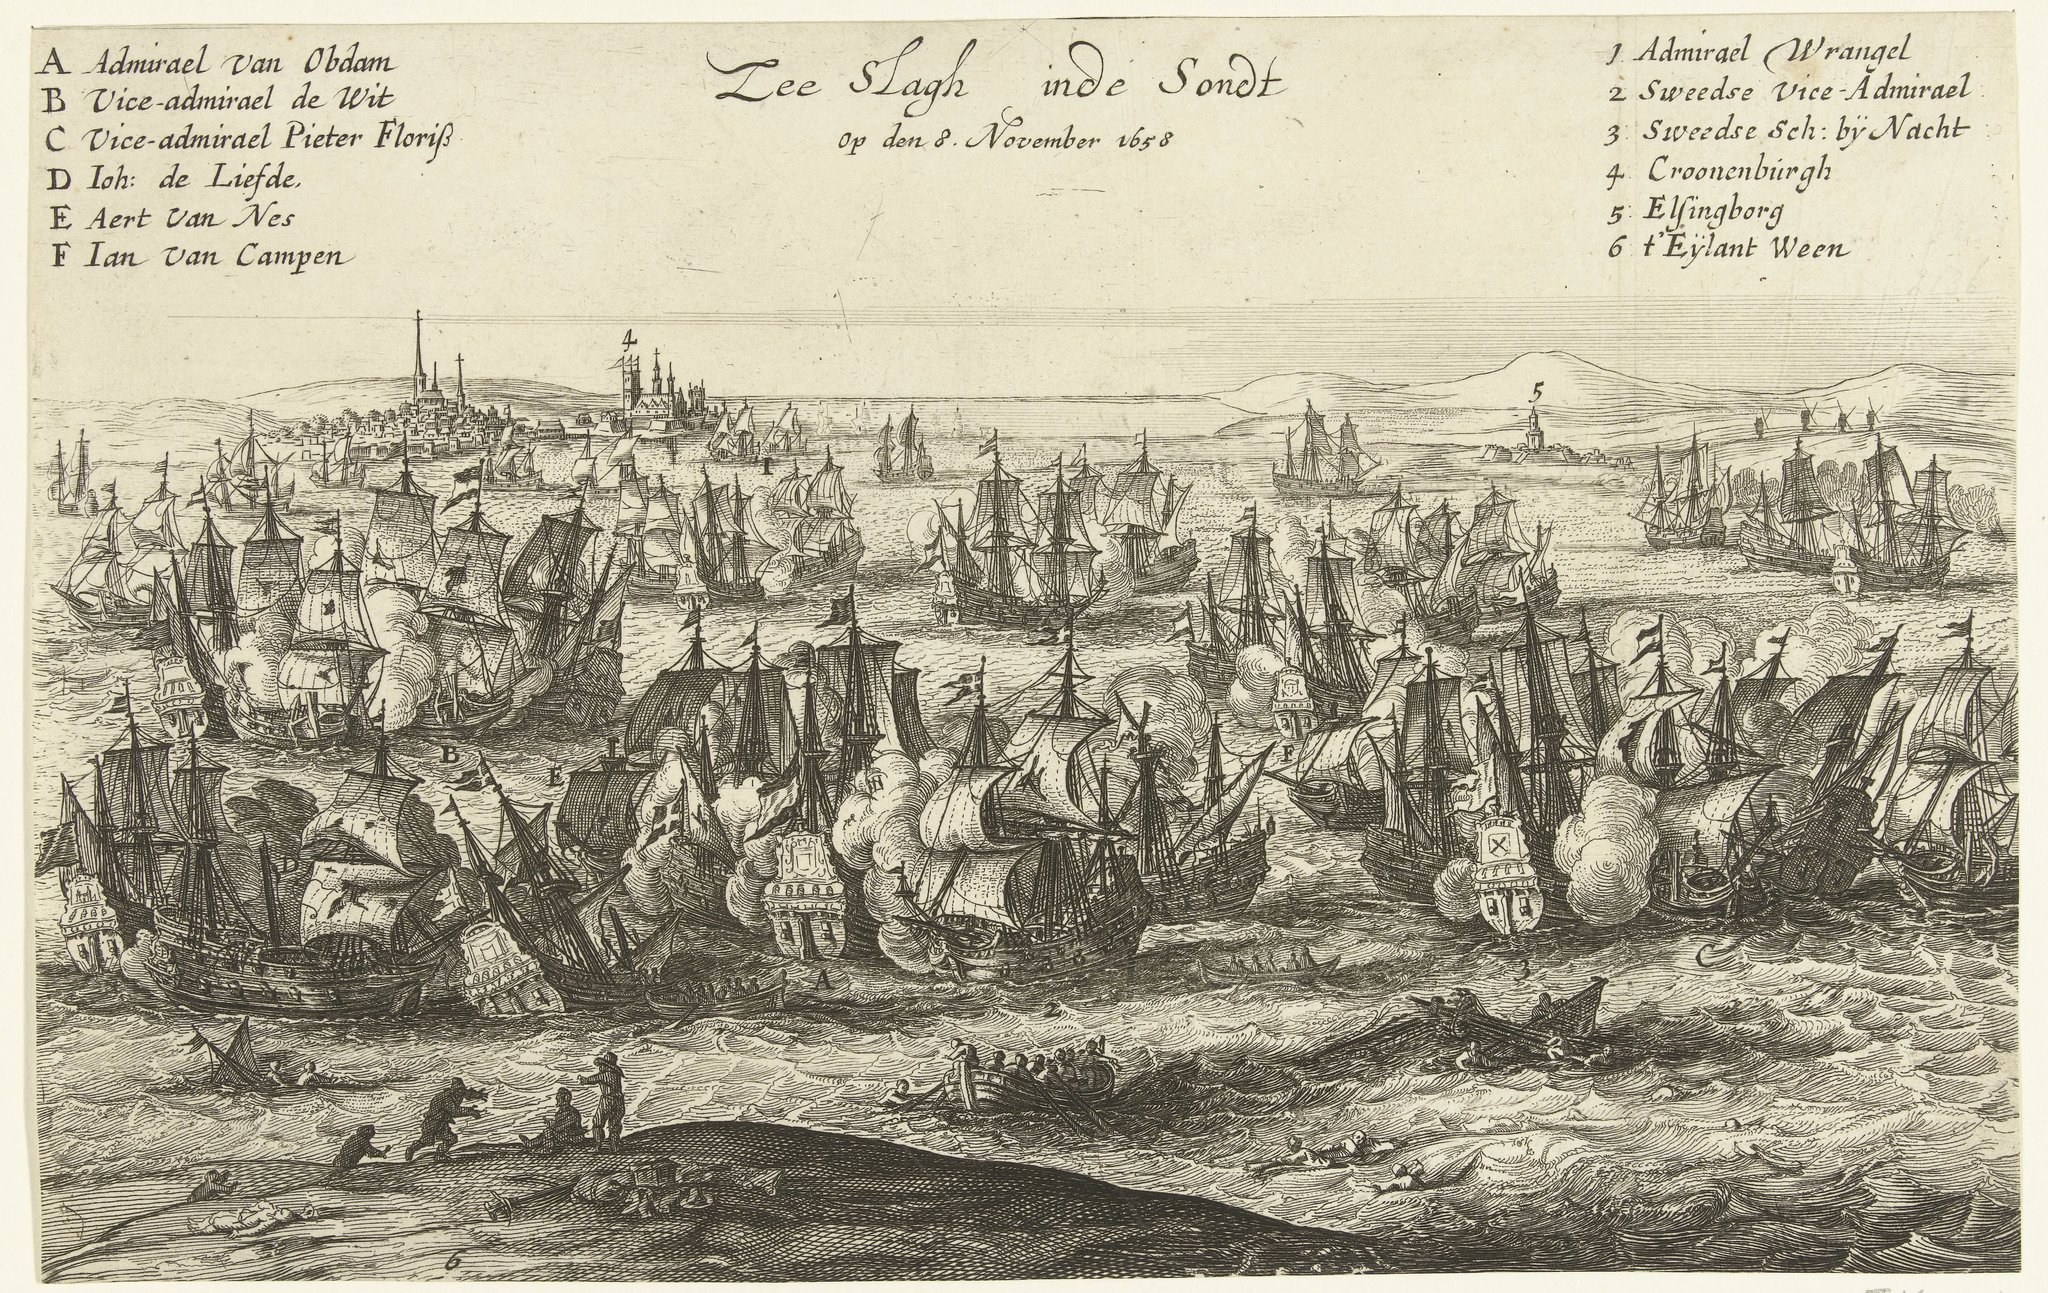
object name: history print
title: Zee Slagh inde Sont Op den 8. November 1658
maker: Anonymous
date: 1658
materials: paper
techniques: engraving, etching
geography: northern netherlands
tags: jacob baron van wassenaer heer van obdam, battle (+ naval force)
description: De Slag in de Sont, tussen de Staatse vloot onder admiraal Jacob baron van Wassenaer, heer van Obdam, en de Zweedse vloot onder admiraal Carl Gustaf Wrangel, 8 november 1658. Bovenaan de legenda's A-F (links) en 1-6 (rechts).